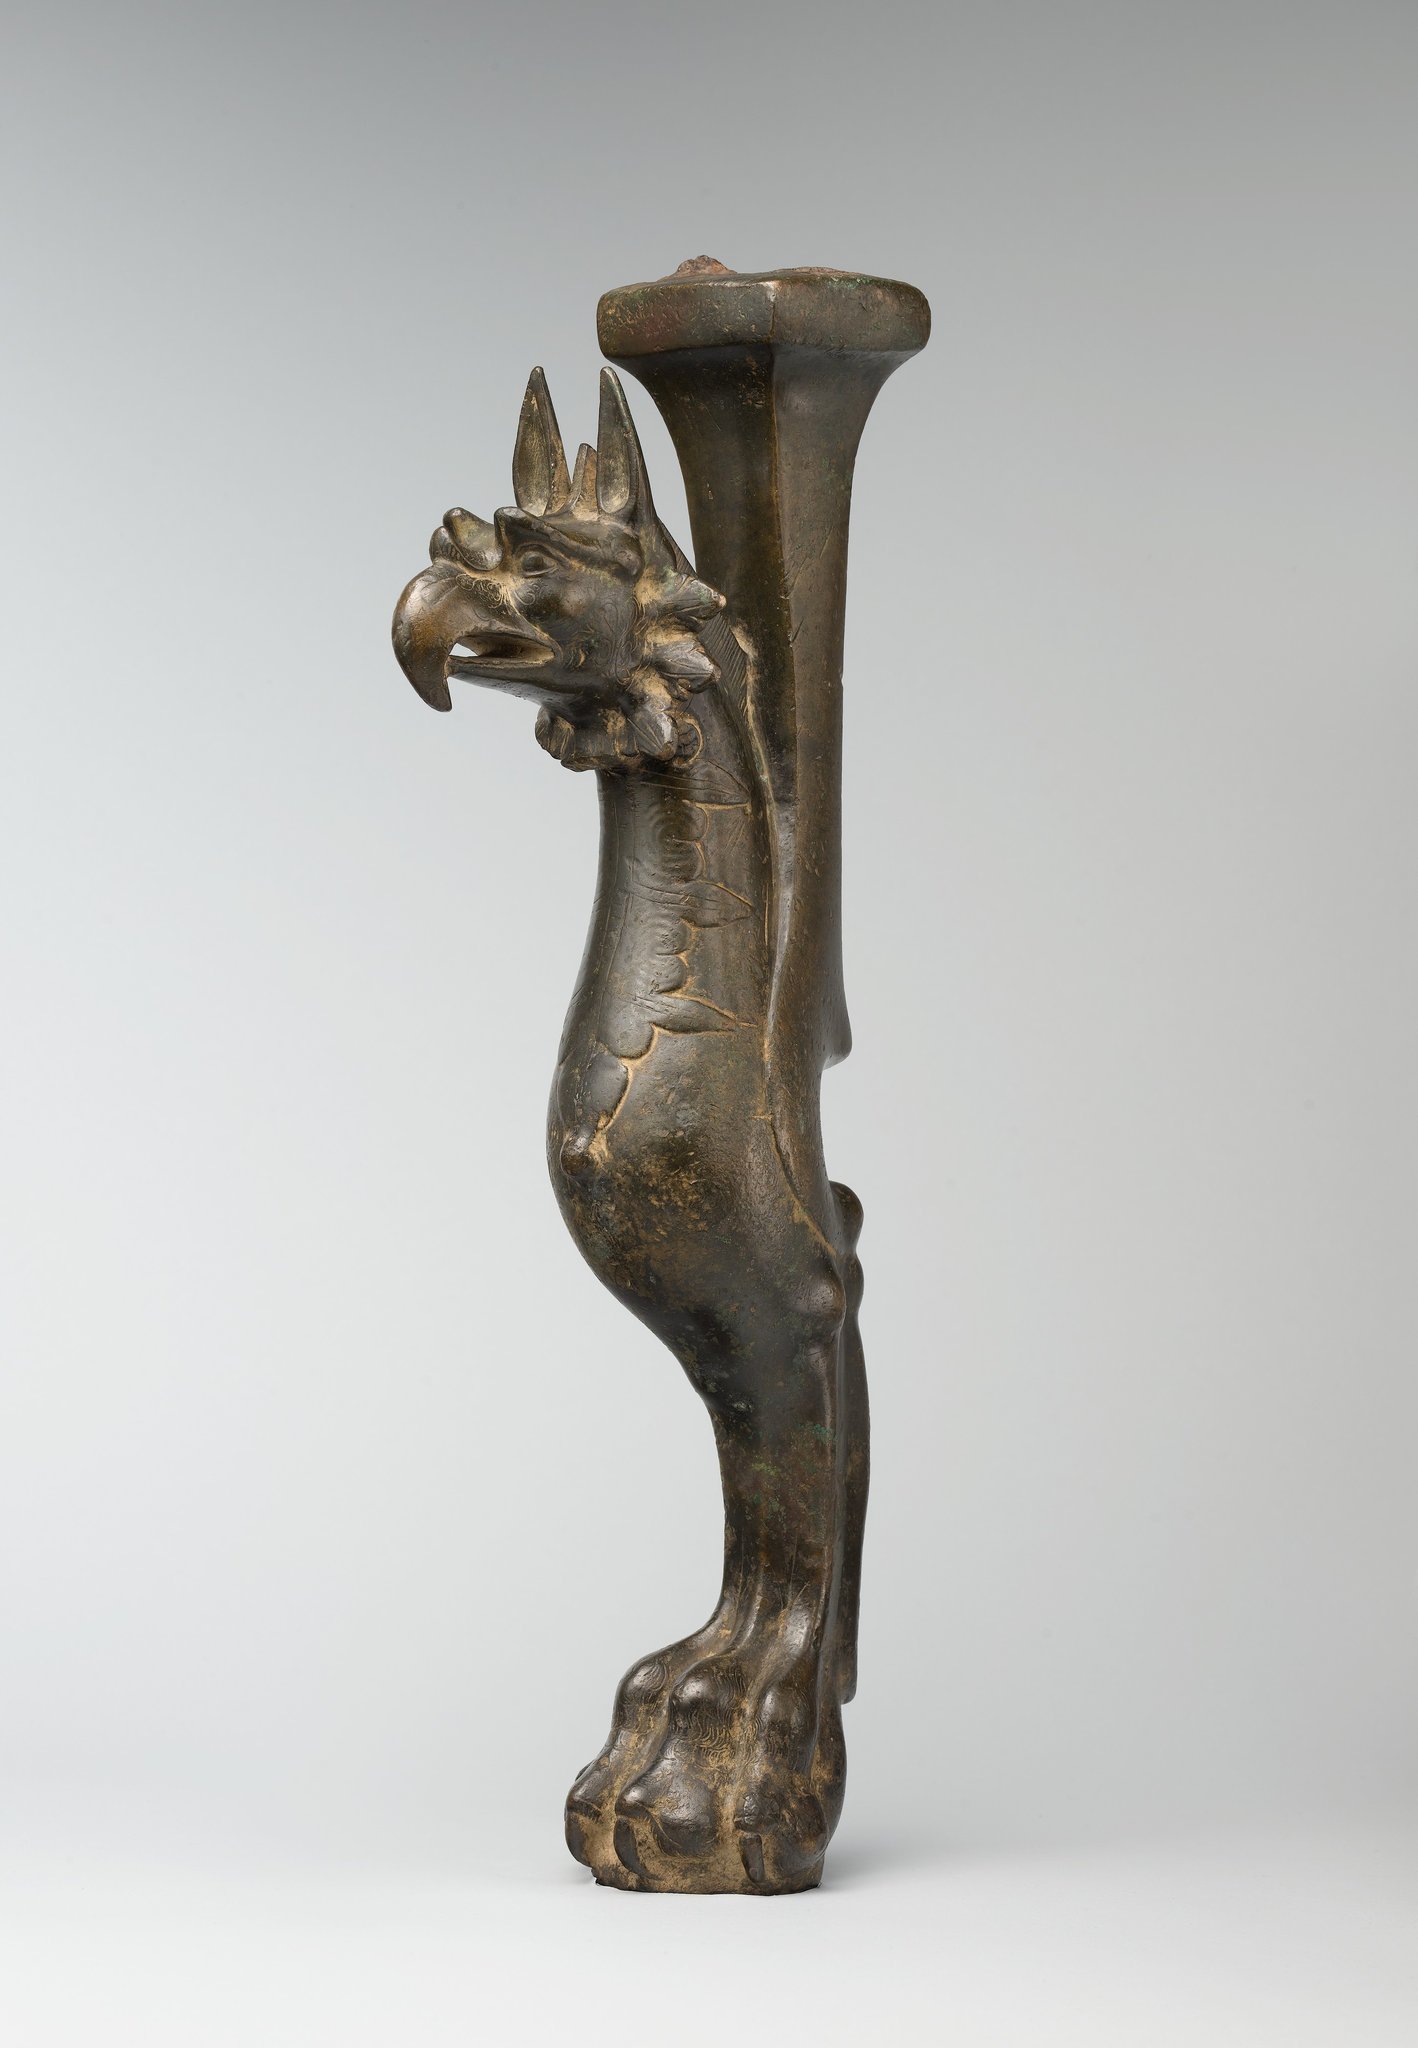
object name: throne leg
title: Throne Leg in the Shape of a Griffin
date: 667-733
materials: bronze, ceramic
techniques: casting, chasing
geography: iran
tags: griffins